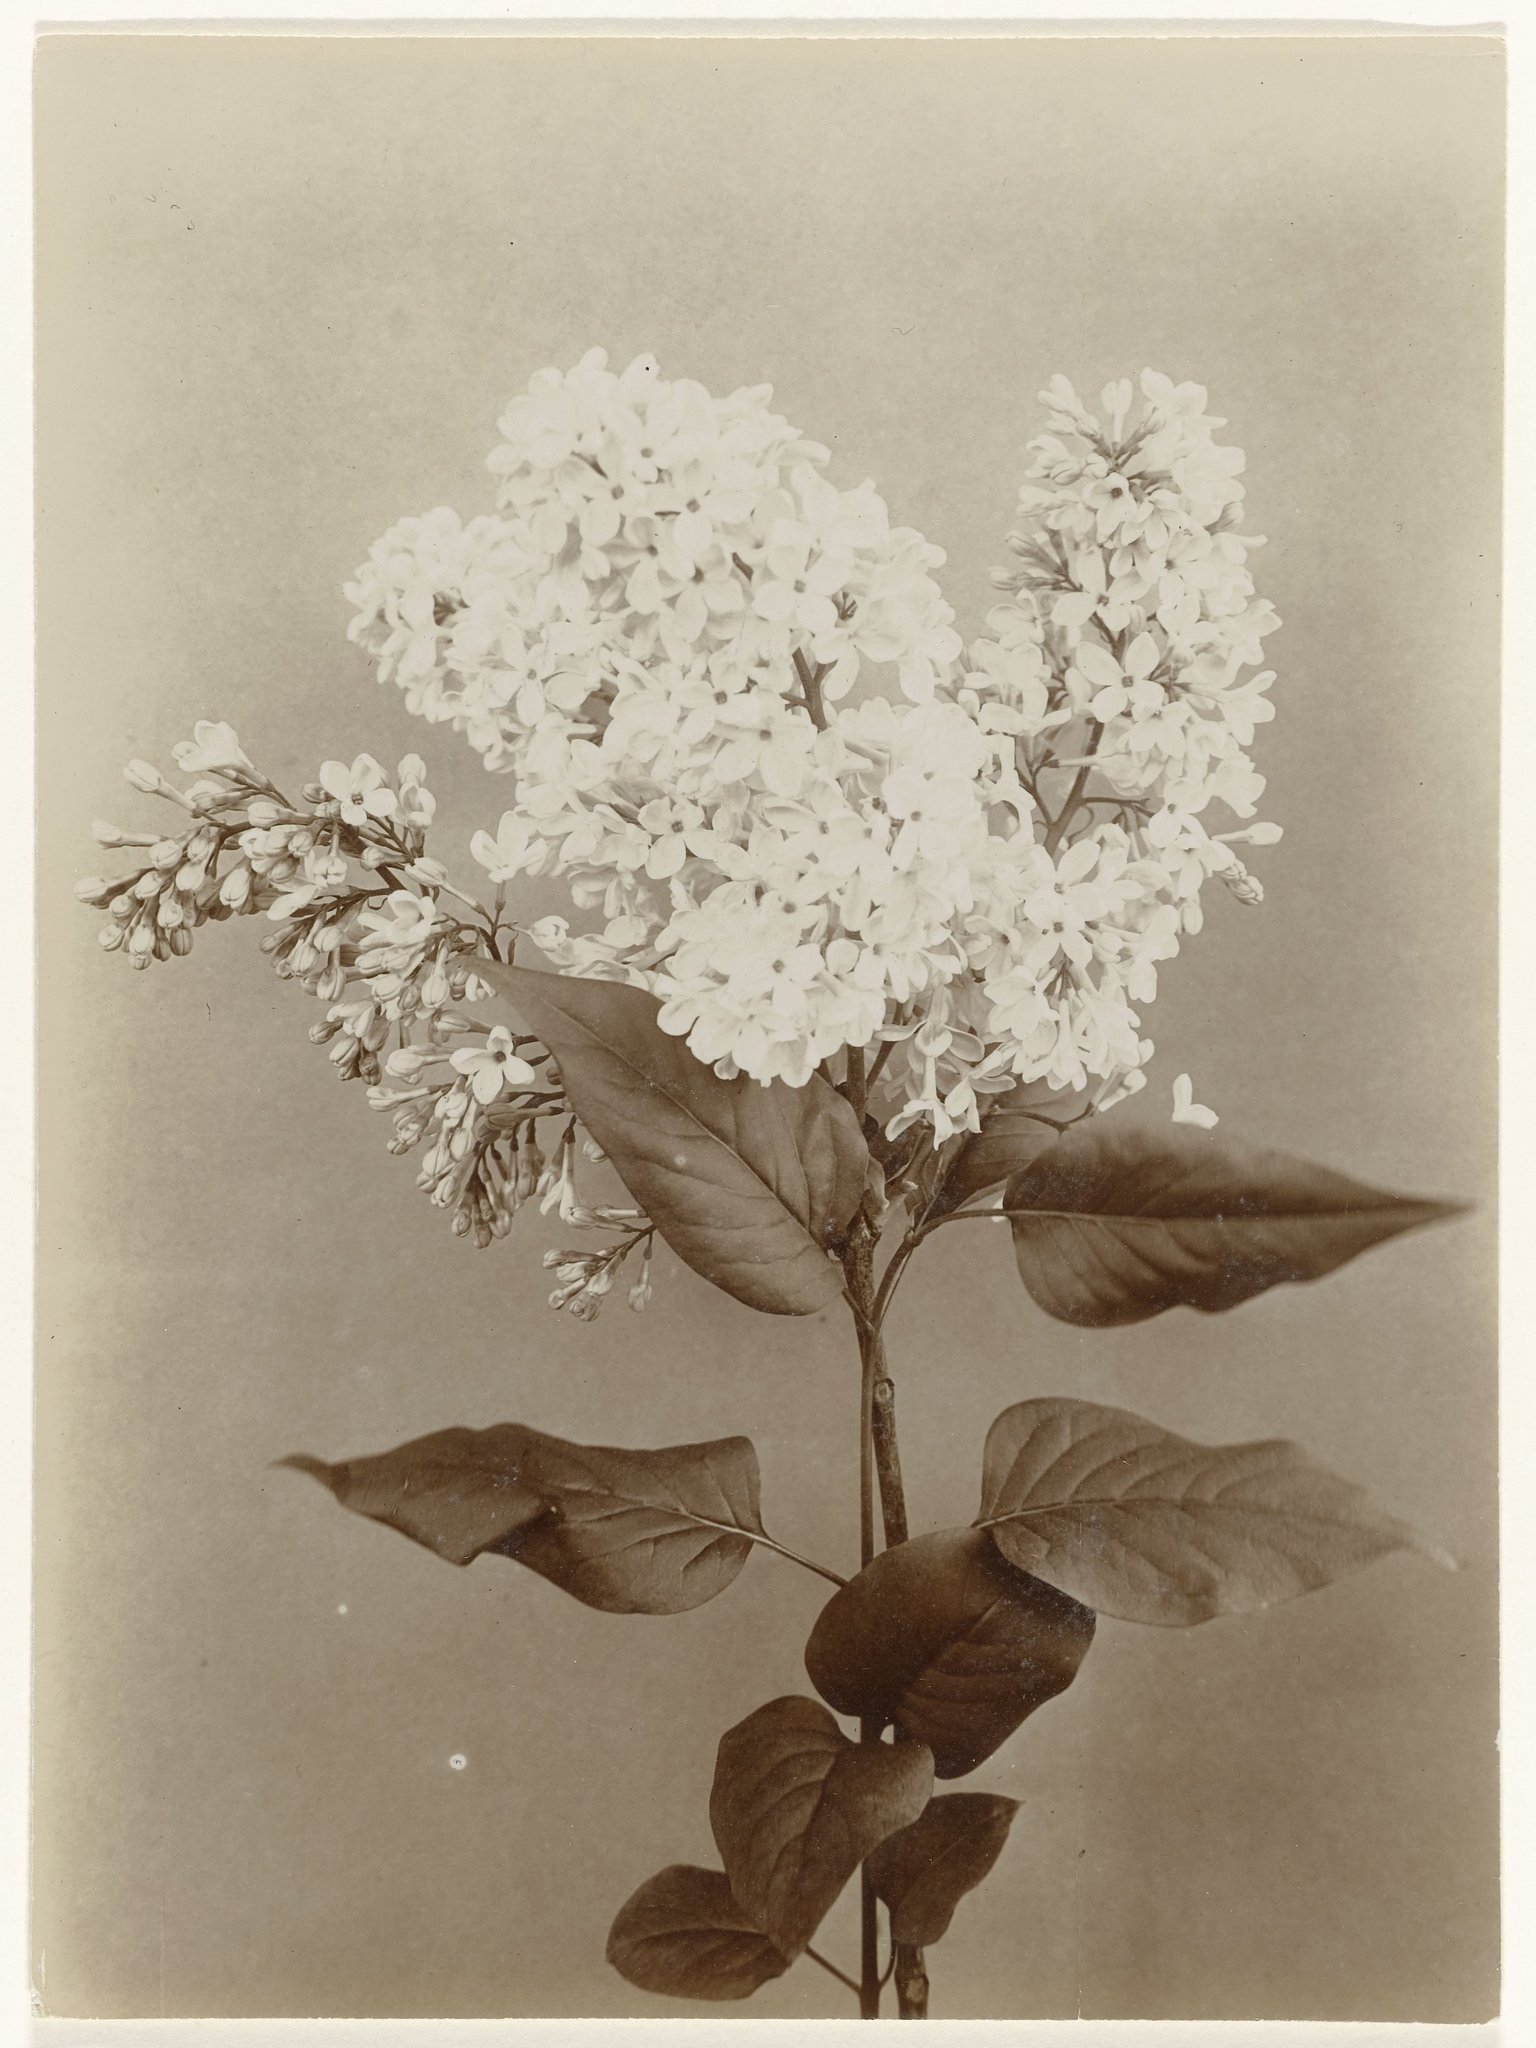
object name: photograph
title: Bloeiende tak met seringen tegen egale achtergrond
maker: richard tepe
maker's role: fotograaf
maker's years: 1864-1952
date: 1900-1940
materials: photographic support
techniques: gelatin silver print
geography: netherlands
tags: flowers: lilac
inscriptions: : ‘Sering / ....... / bloeiende tak / uit Aalsmeer’, signature: ‘R Tepe / foto’